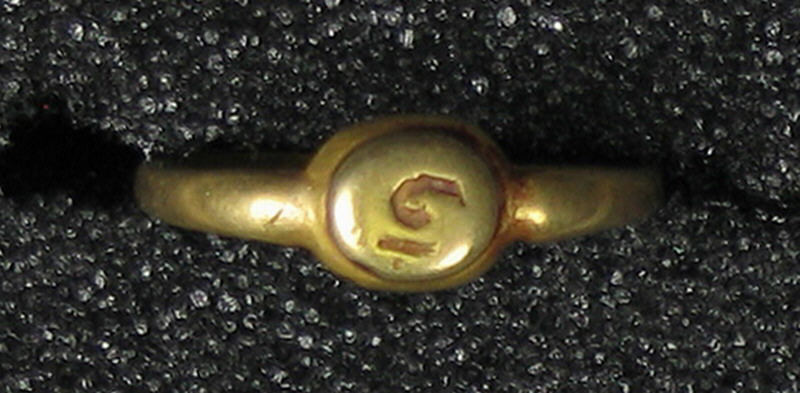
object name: ring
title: Ring with Notched Circle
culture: indonesian, central java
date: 701-1200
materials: gold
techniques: casting